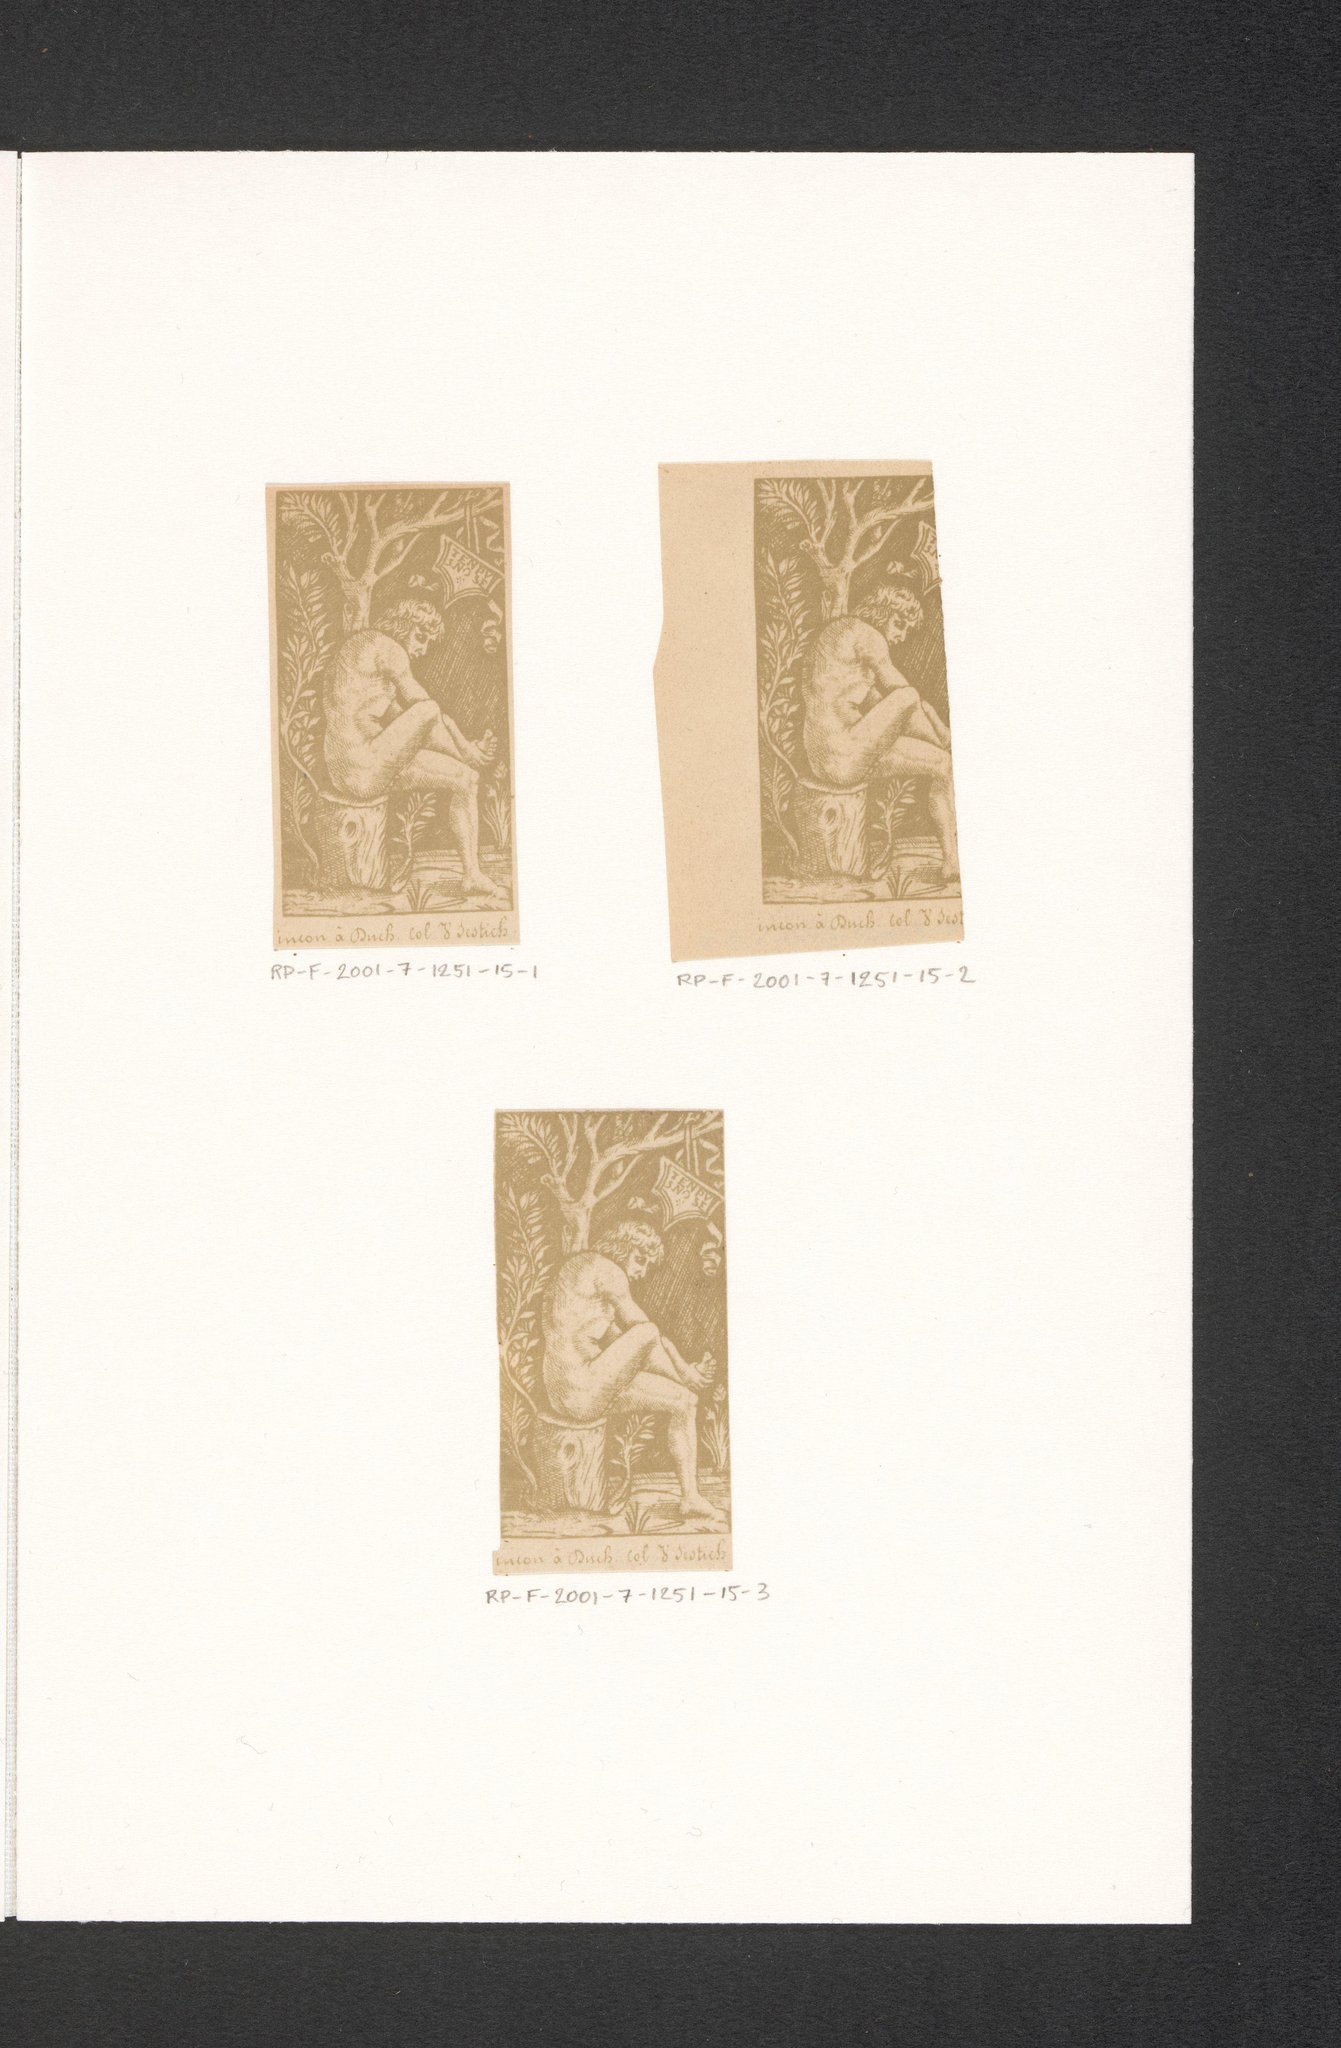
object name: reproduction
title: Fotoreproductie van een prent van de Spinario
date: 1852-1857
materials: photographic support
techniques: salted paper print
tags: 'spinario', child pulling a thorn out of its foot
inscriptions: inscription: ‘incon à Duch. col V. Sestich’